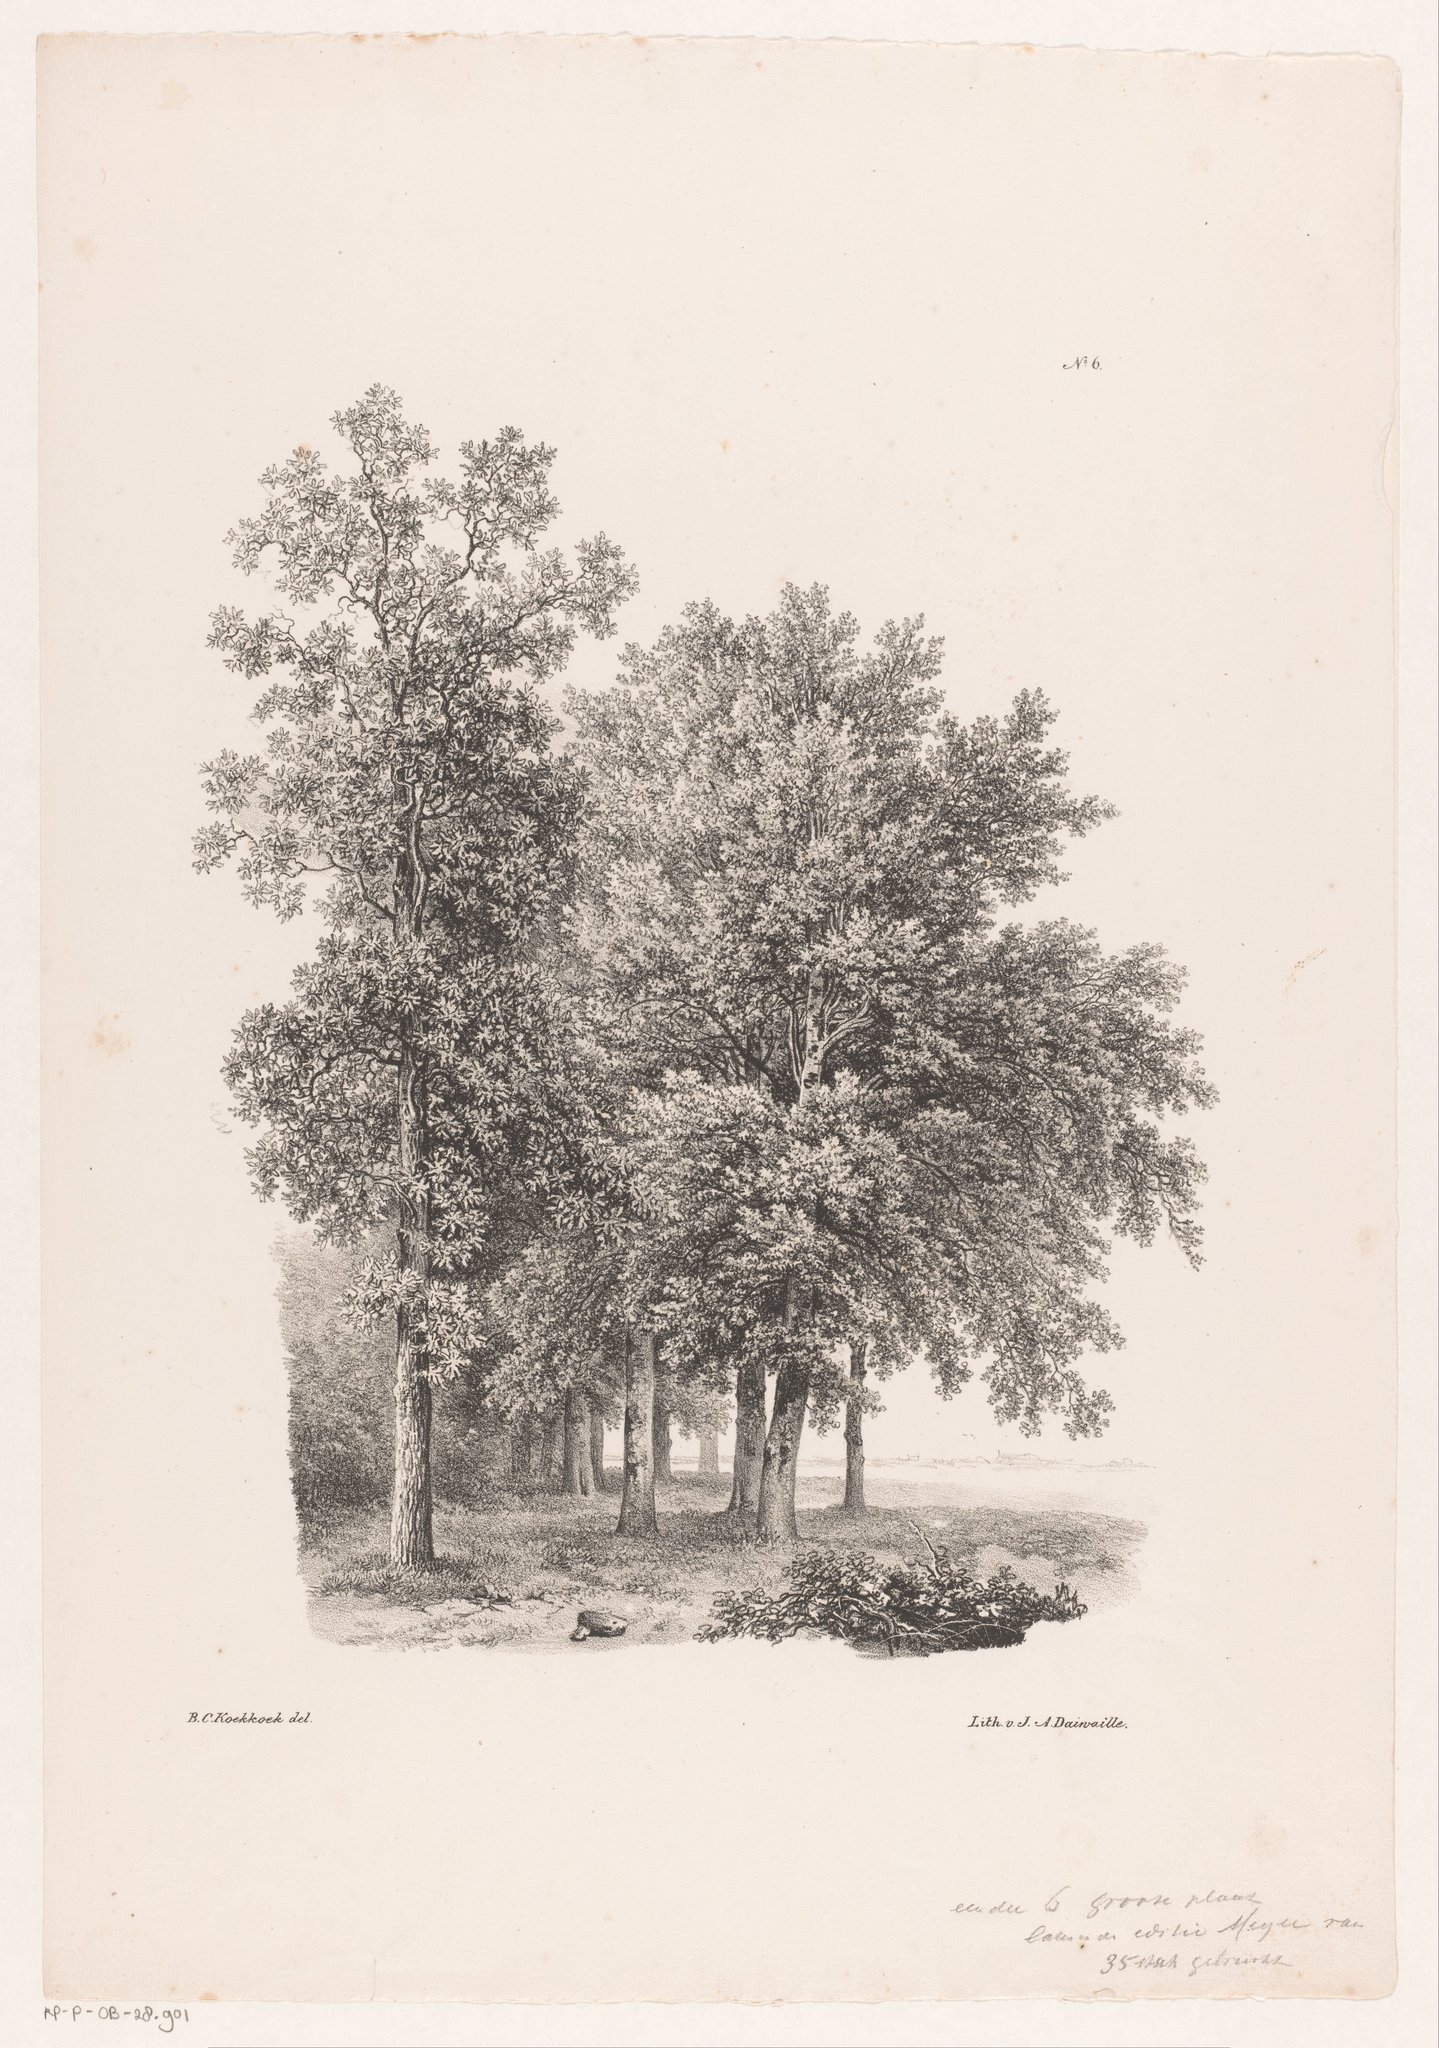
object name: print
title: Bomen naast een weiland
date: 1829-1830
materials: paper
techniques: lithograph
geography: amsterdam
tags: groups of trees, plain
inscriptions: collector's mark: Lugt 2228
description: In 1829 en 1830 gaf Koekkoek, samen met Daiwaille, zes cahiers uit met ieder zes prenten getiteld Landschapstudiën. Deze werden gebruikt in het tekenonderwijs. Vijftien jaar later werd deze reeks, in een andere samenstelling nogmaals uitgegeven door Meyer en Comp in Amsterdam. Zie: De Bruyn Kops, 1963 en Nollert, 1997.